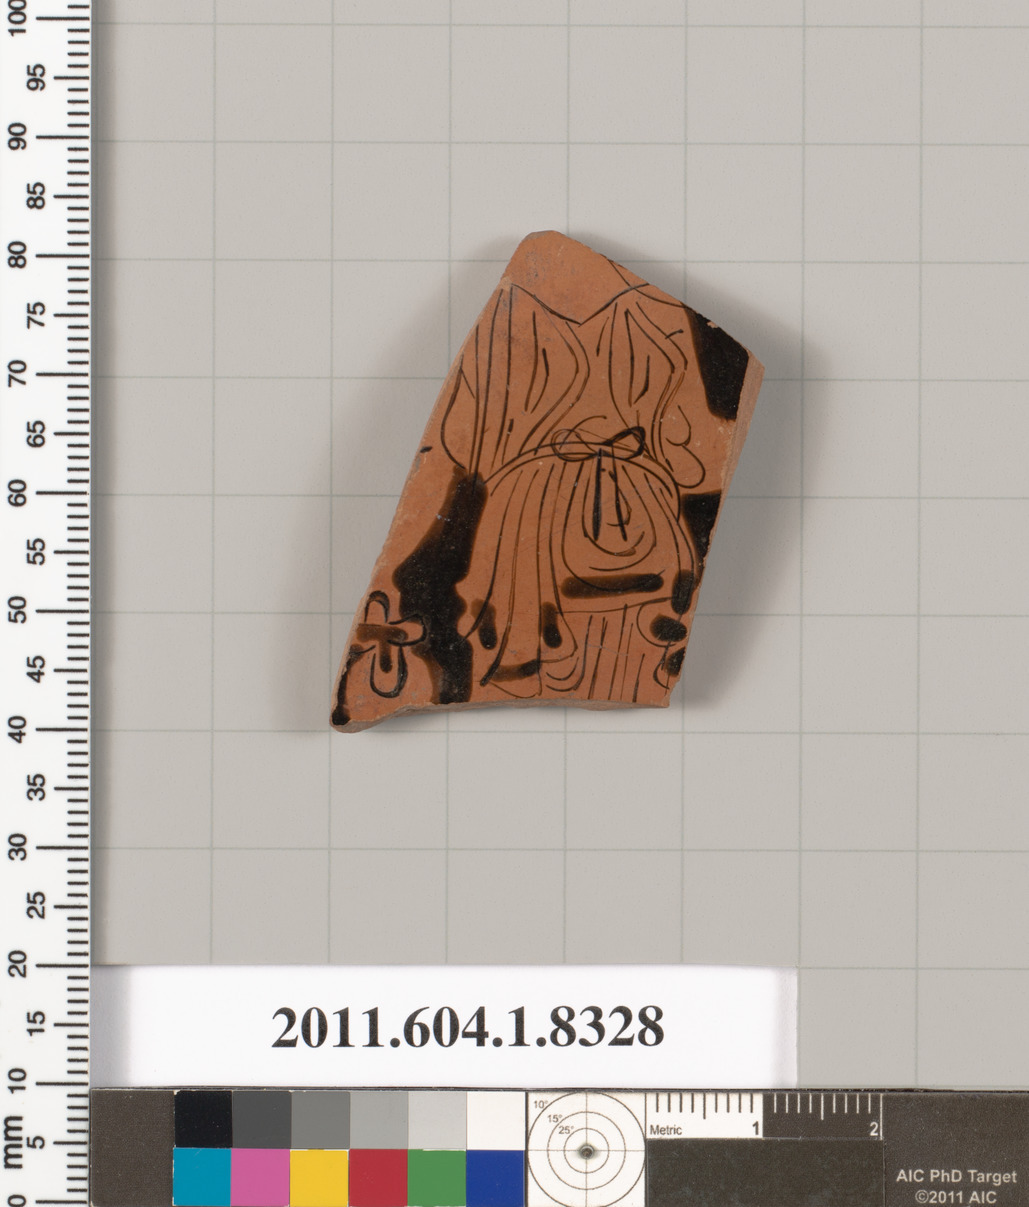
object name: kylix fragment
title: Terracotta fragment of a kylix (drinking cup)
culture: greek, attic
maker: painter of london e 106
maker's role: artist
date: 410-400 BCE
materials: terracotta